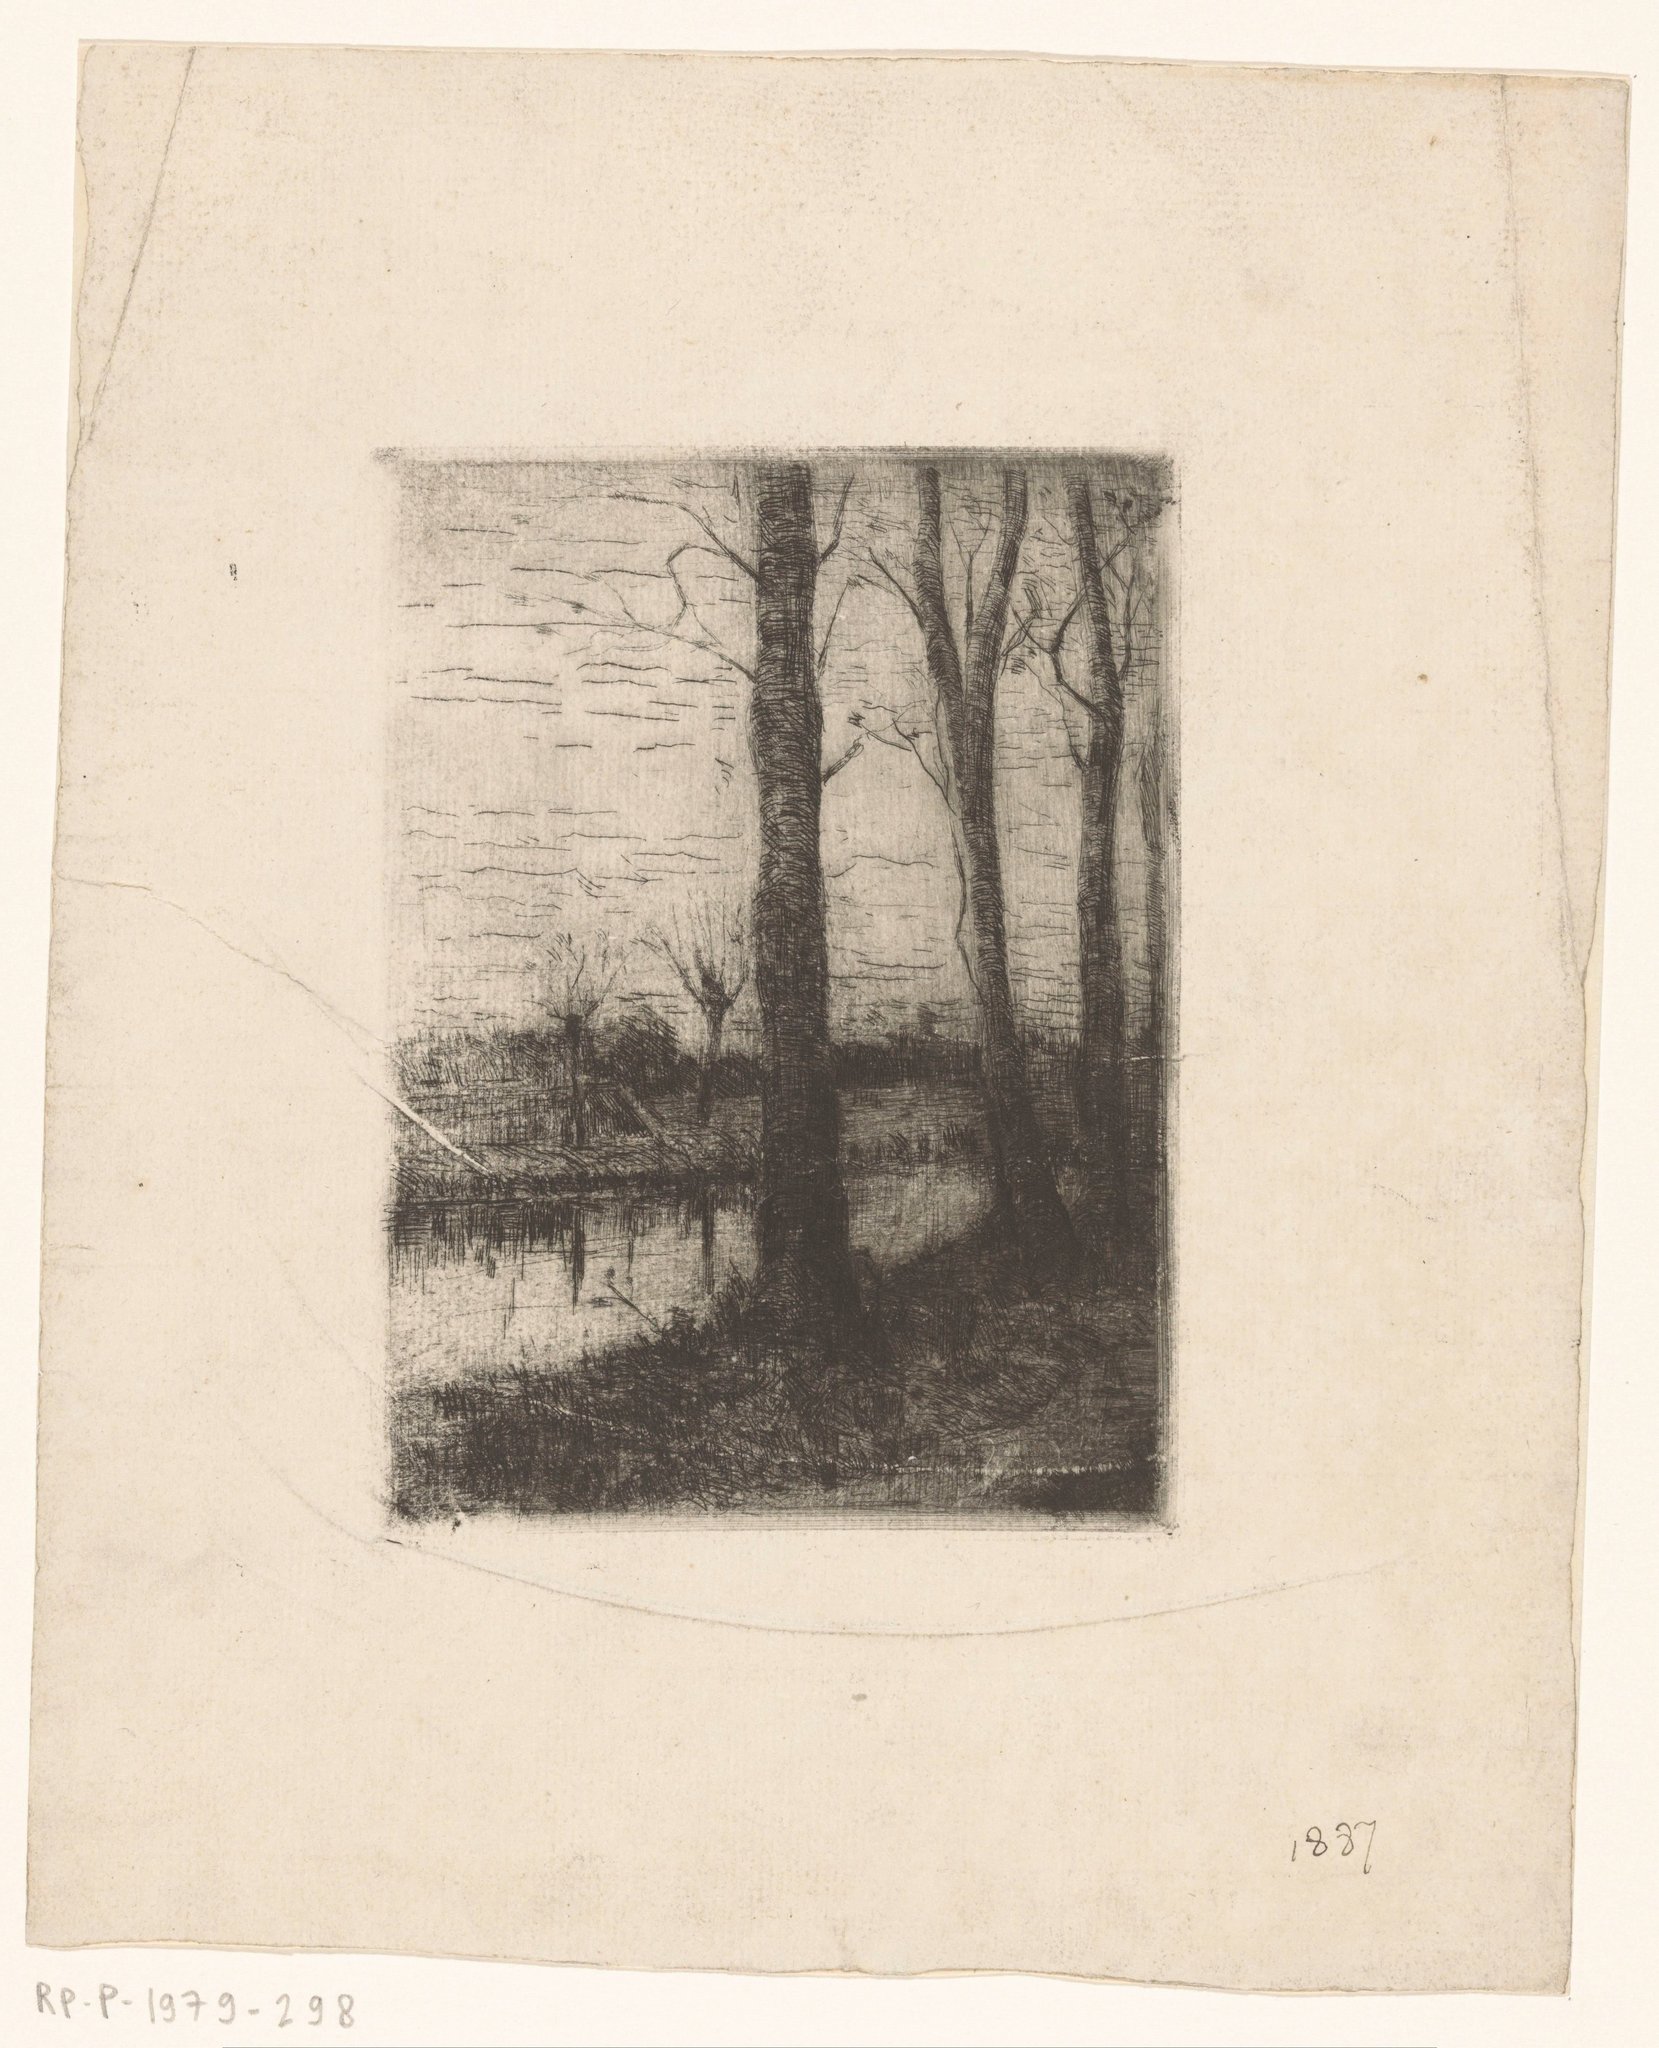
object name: print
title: Bomen langs een vaart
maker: richard nicolaüs roland holst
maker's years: 1868-1938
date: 1887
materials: paper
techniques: etching, intaglio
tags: trees, canal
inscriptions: collector's mark: Lugt 2228